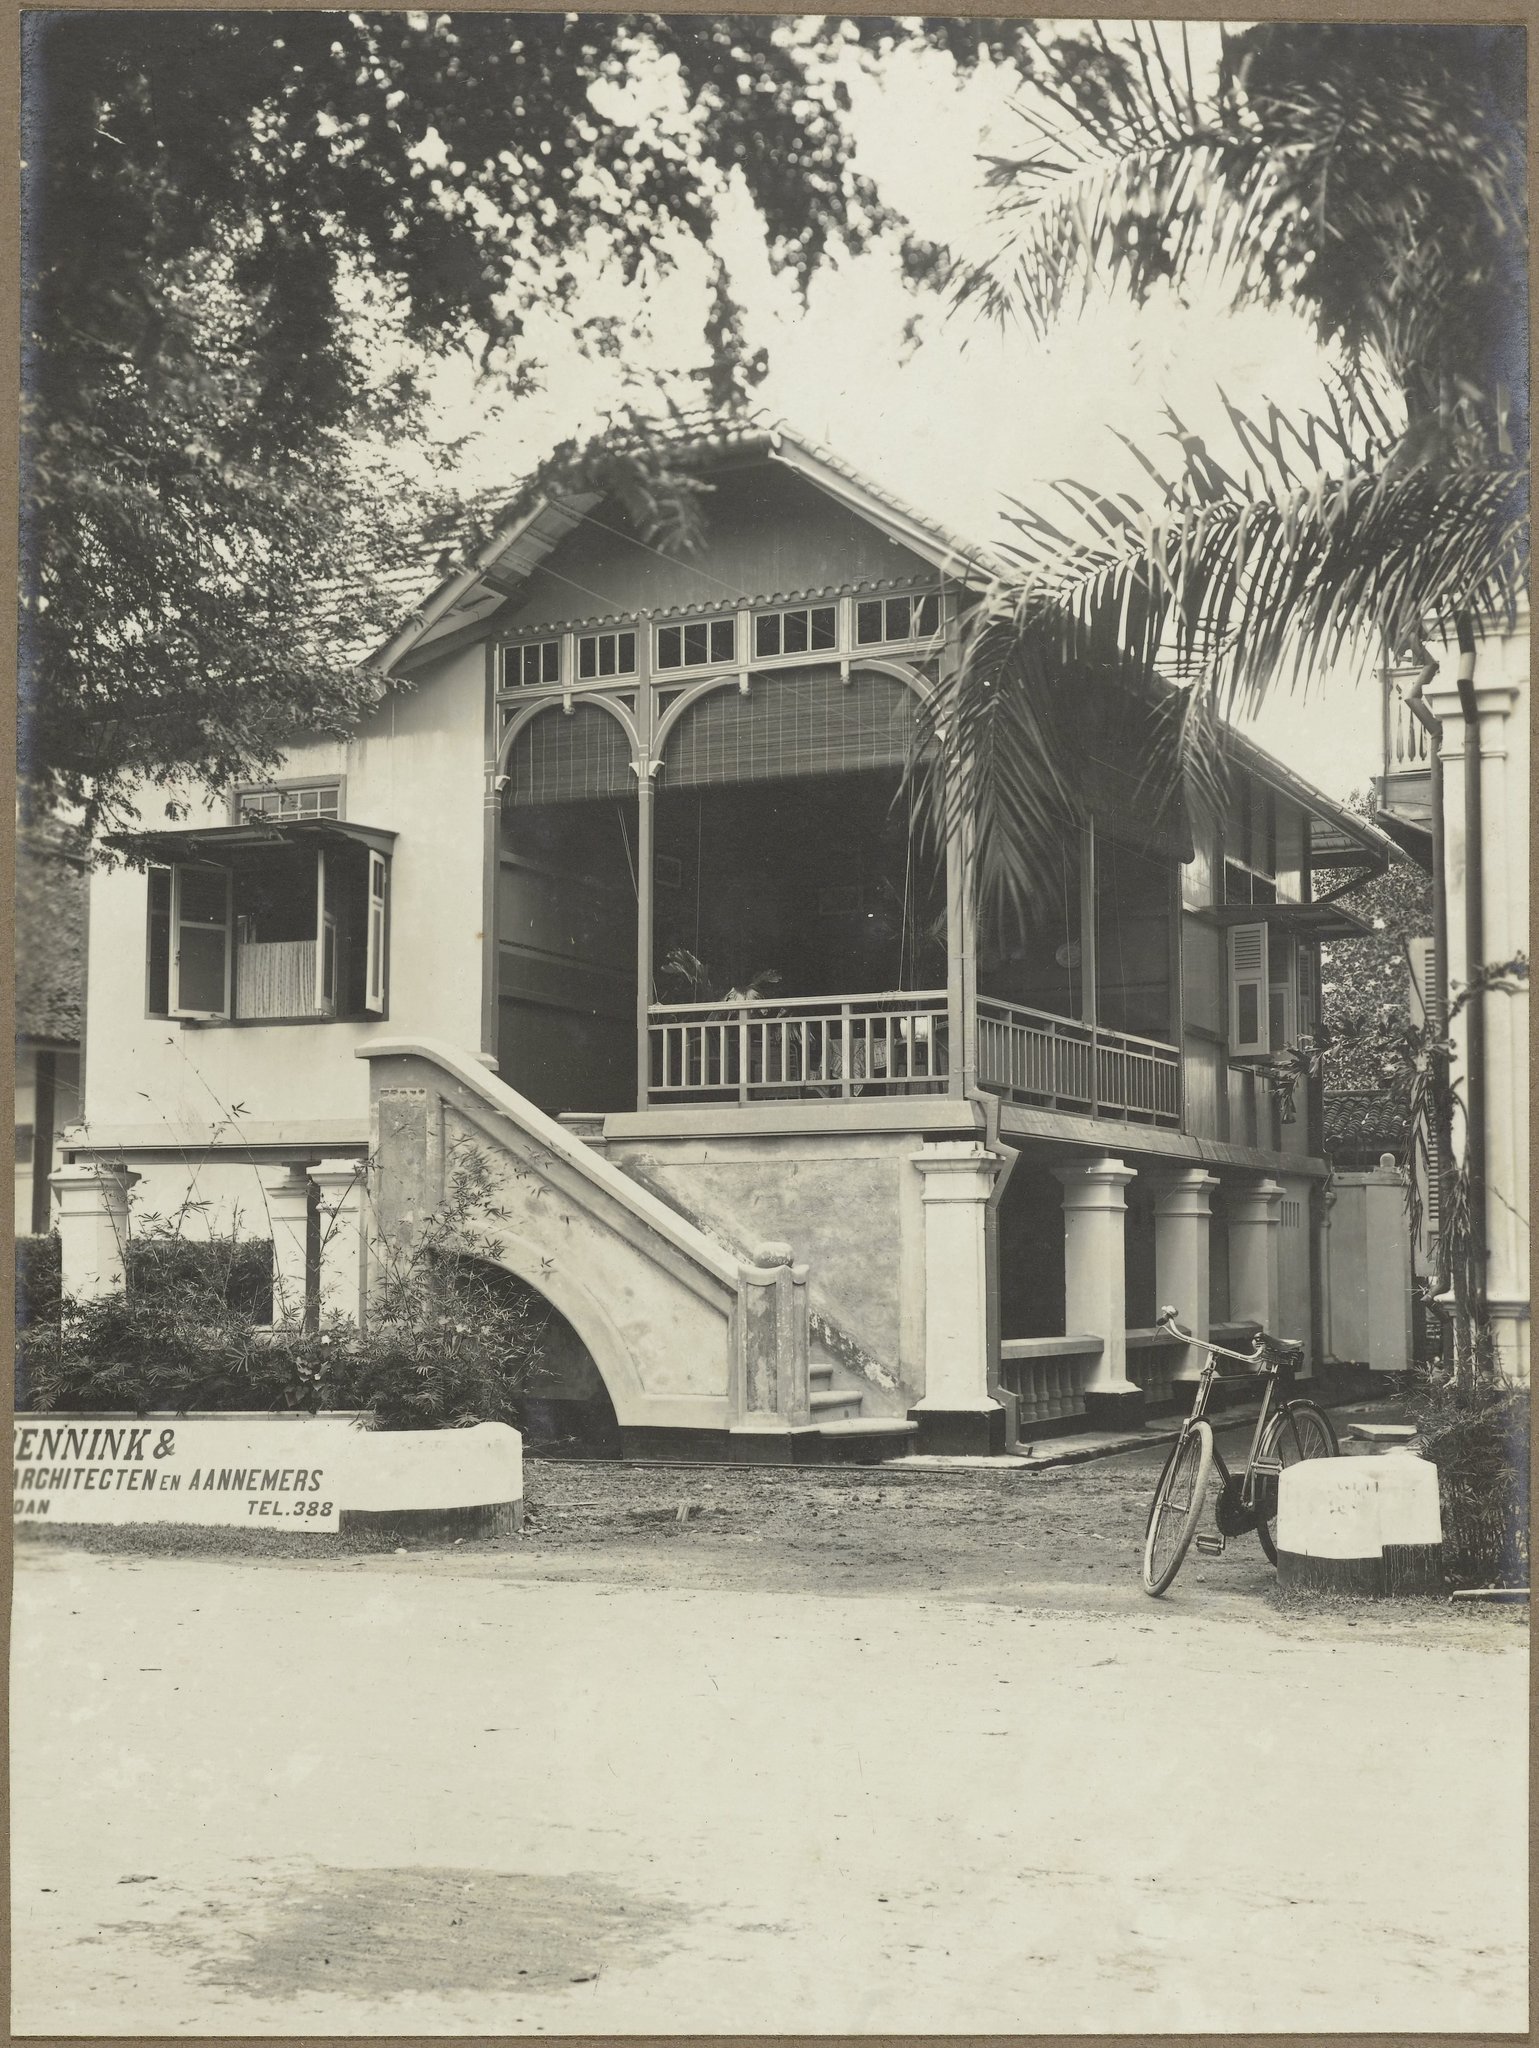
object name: photograph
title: Achterzijde van het gebouw van Rathkamp & Co.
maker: Anonymous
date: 1914-1919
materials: photographic support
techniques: gelatin silver print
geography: medan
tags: representation of real building (either existing or having existed), architecture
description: De achterzijde van het gebouw van de apotheek Rathkamp & Co., waarschijnlijk te Medan. Foto in het fotoalbum van het Nederlandse architectenbureau en aannemersbedrijf Bennink en Riphagen te Medan in de jaren ca. 1914-1919.